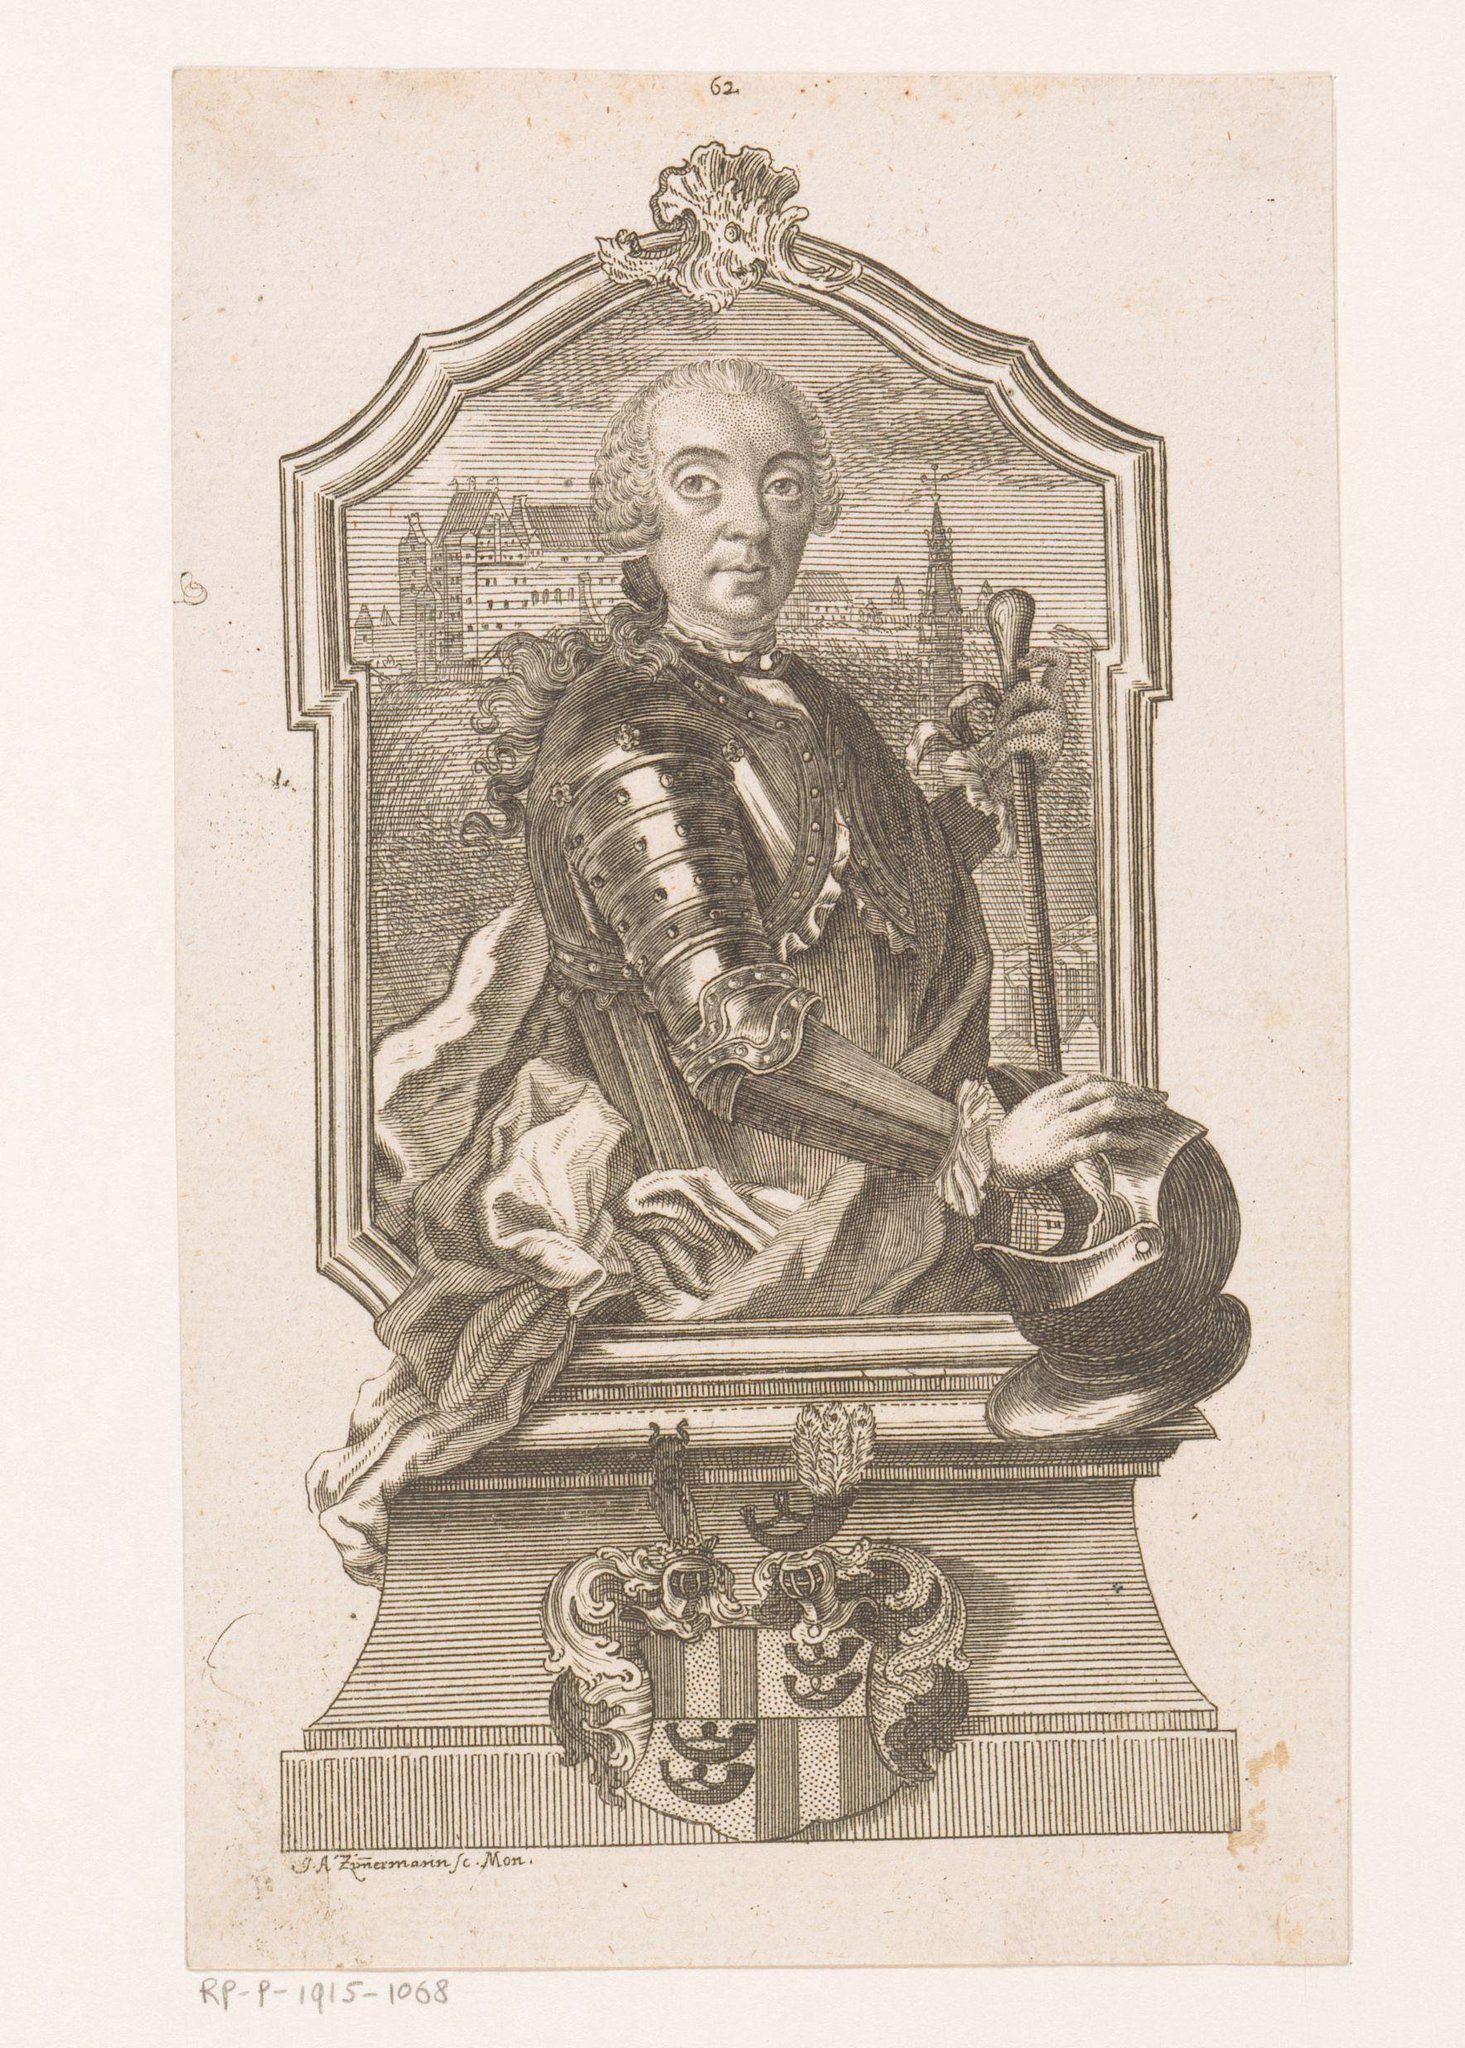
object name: print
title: Portret van een man, mogelijk Max von Franehofen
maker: joseph anton zimmermann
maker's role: draughtsman, print maker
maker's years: 1705-1797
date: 1715-1797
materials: paper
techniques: engraving, etching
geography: germany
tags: historical persons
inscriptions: collector's mark: Lugt 2228